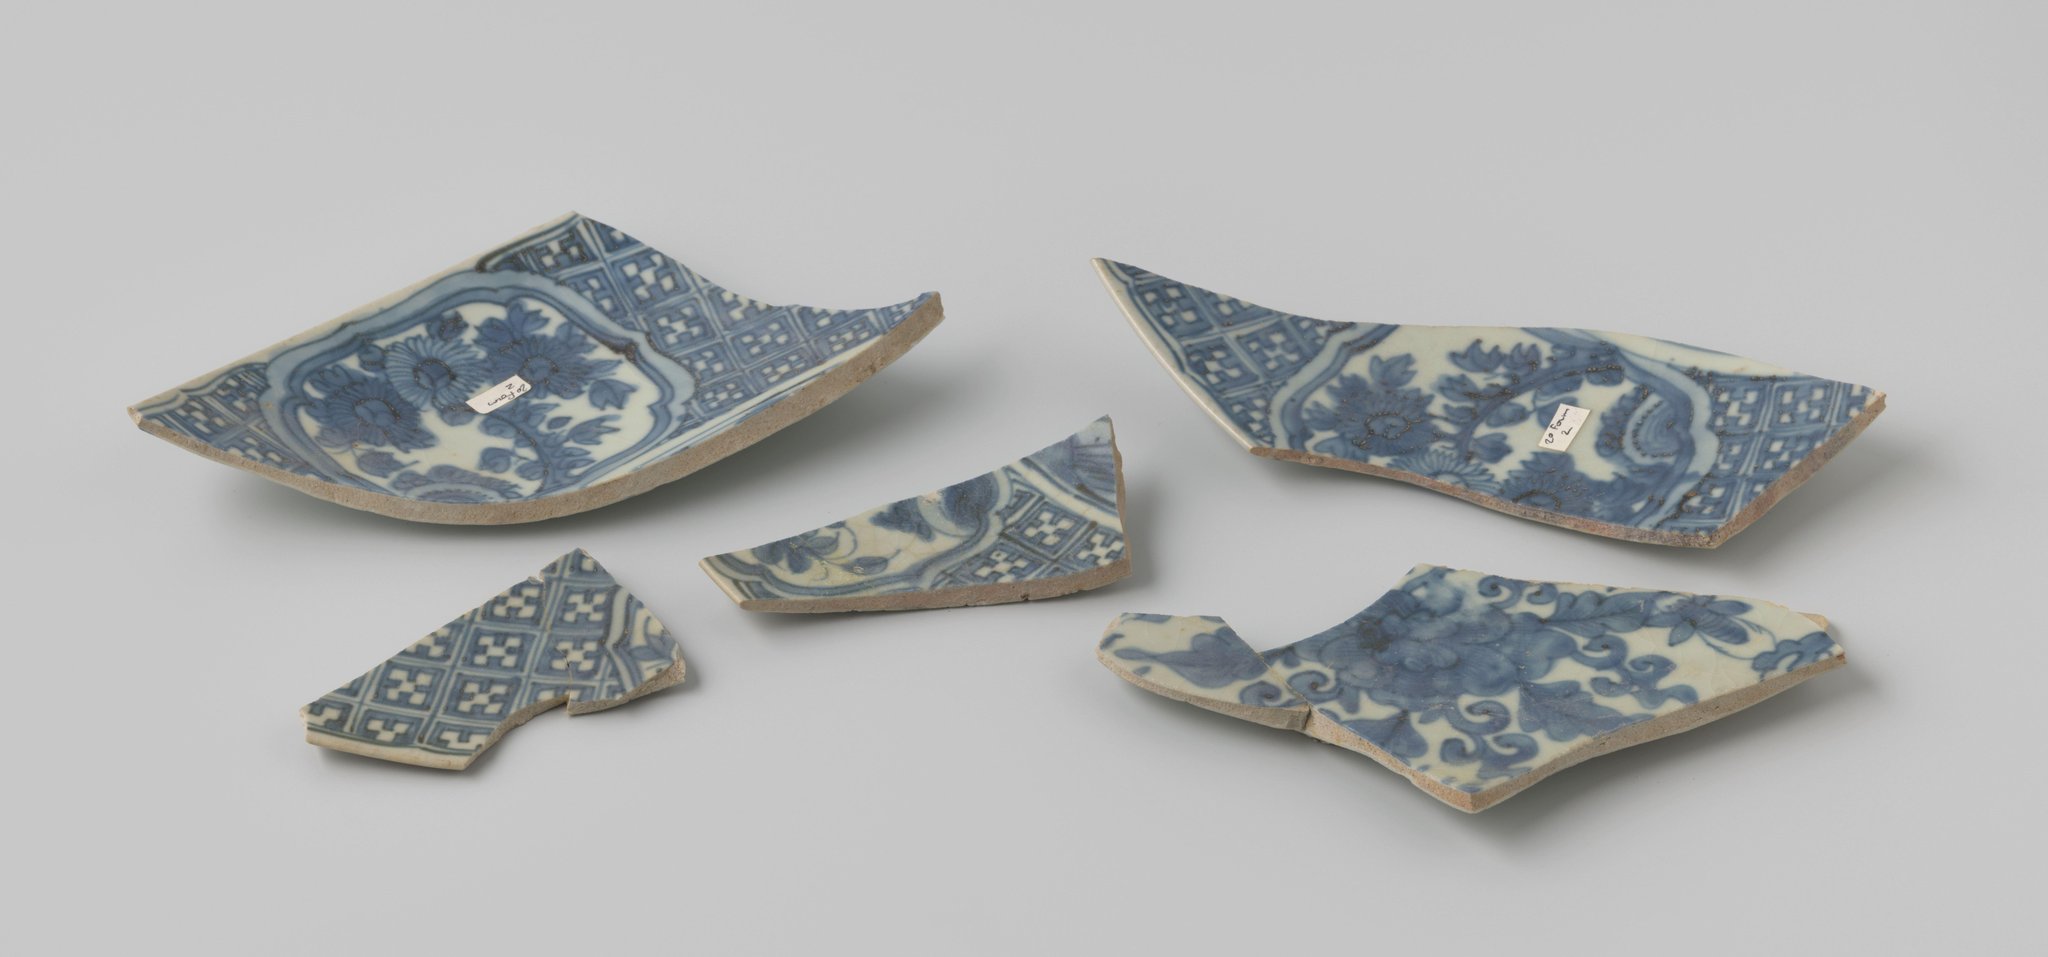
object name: plate dish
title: Scherven Swatow-porselein uit V.O.C.-schip de 'Witte Leeuw'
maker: Anonymous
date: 1613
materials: bone china, porcelain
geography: shantou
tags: verenigde oostindische compagnie, sint-helena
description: A large dish. The body is of a thick light grey porcelain with no impurities. The milky glaze is transparant and uncrackled. The underglaze blue is very light blue. In the centre a water landscape with ducks. On the walls medaillions with a white frame edged with blue in which a floral design is painted. These are separated by 9 narrow bands. On the outside are two wavy ribbons and a thin band around the liprim.